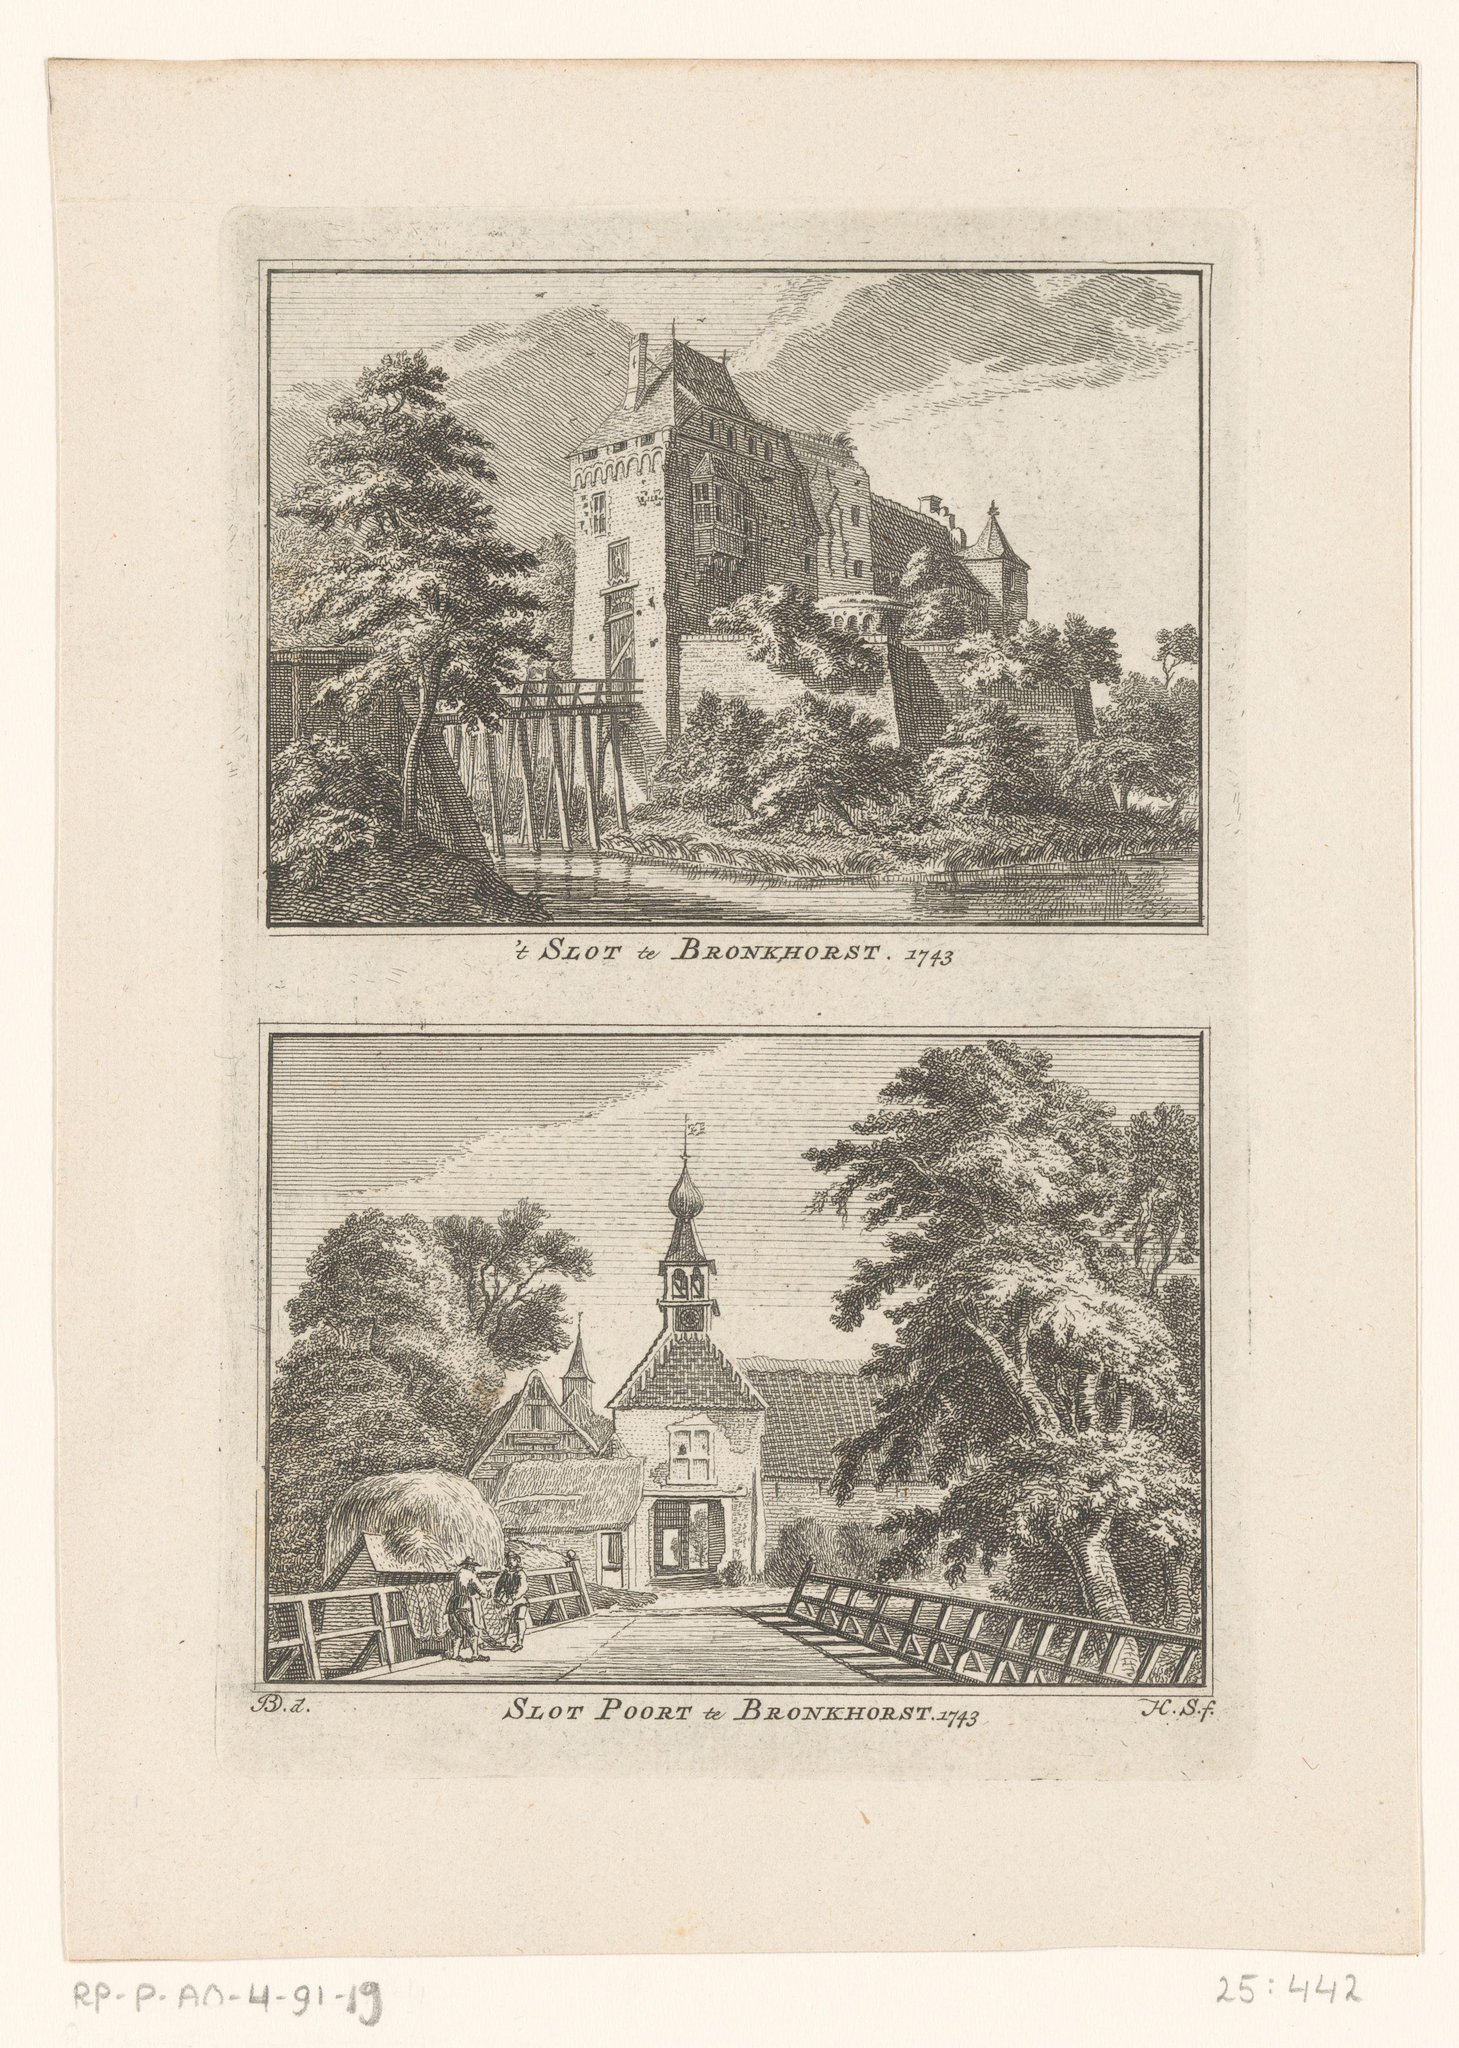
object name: print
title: 't Slot te Bronkhorst. 1743 / Slot poort te Bronkhorst. 1743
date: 1745-1792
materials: paper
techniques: etching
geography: haarlem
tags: castle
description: Prent ook gebruikt in: Het verheerlykt Nederland of kabinet van hedendaagsche gezigten van steden, dorpen (…). 9 delen. Amsterdam: Isaak Tirion en weduwe Isaak Tirion, 1745-1774, dl. 1 (1745), ill. 59-60. Of in: Nederlandsche tafereelen; of eene keurige verzameling van negen honderd fraaije gezigten van steden, dorpen, sloten, oudheden (….). 9 delen. Amsterdam: Jan de Groot, 1792, dl. 1, ill. 59-60.